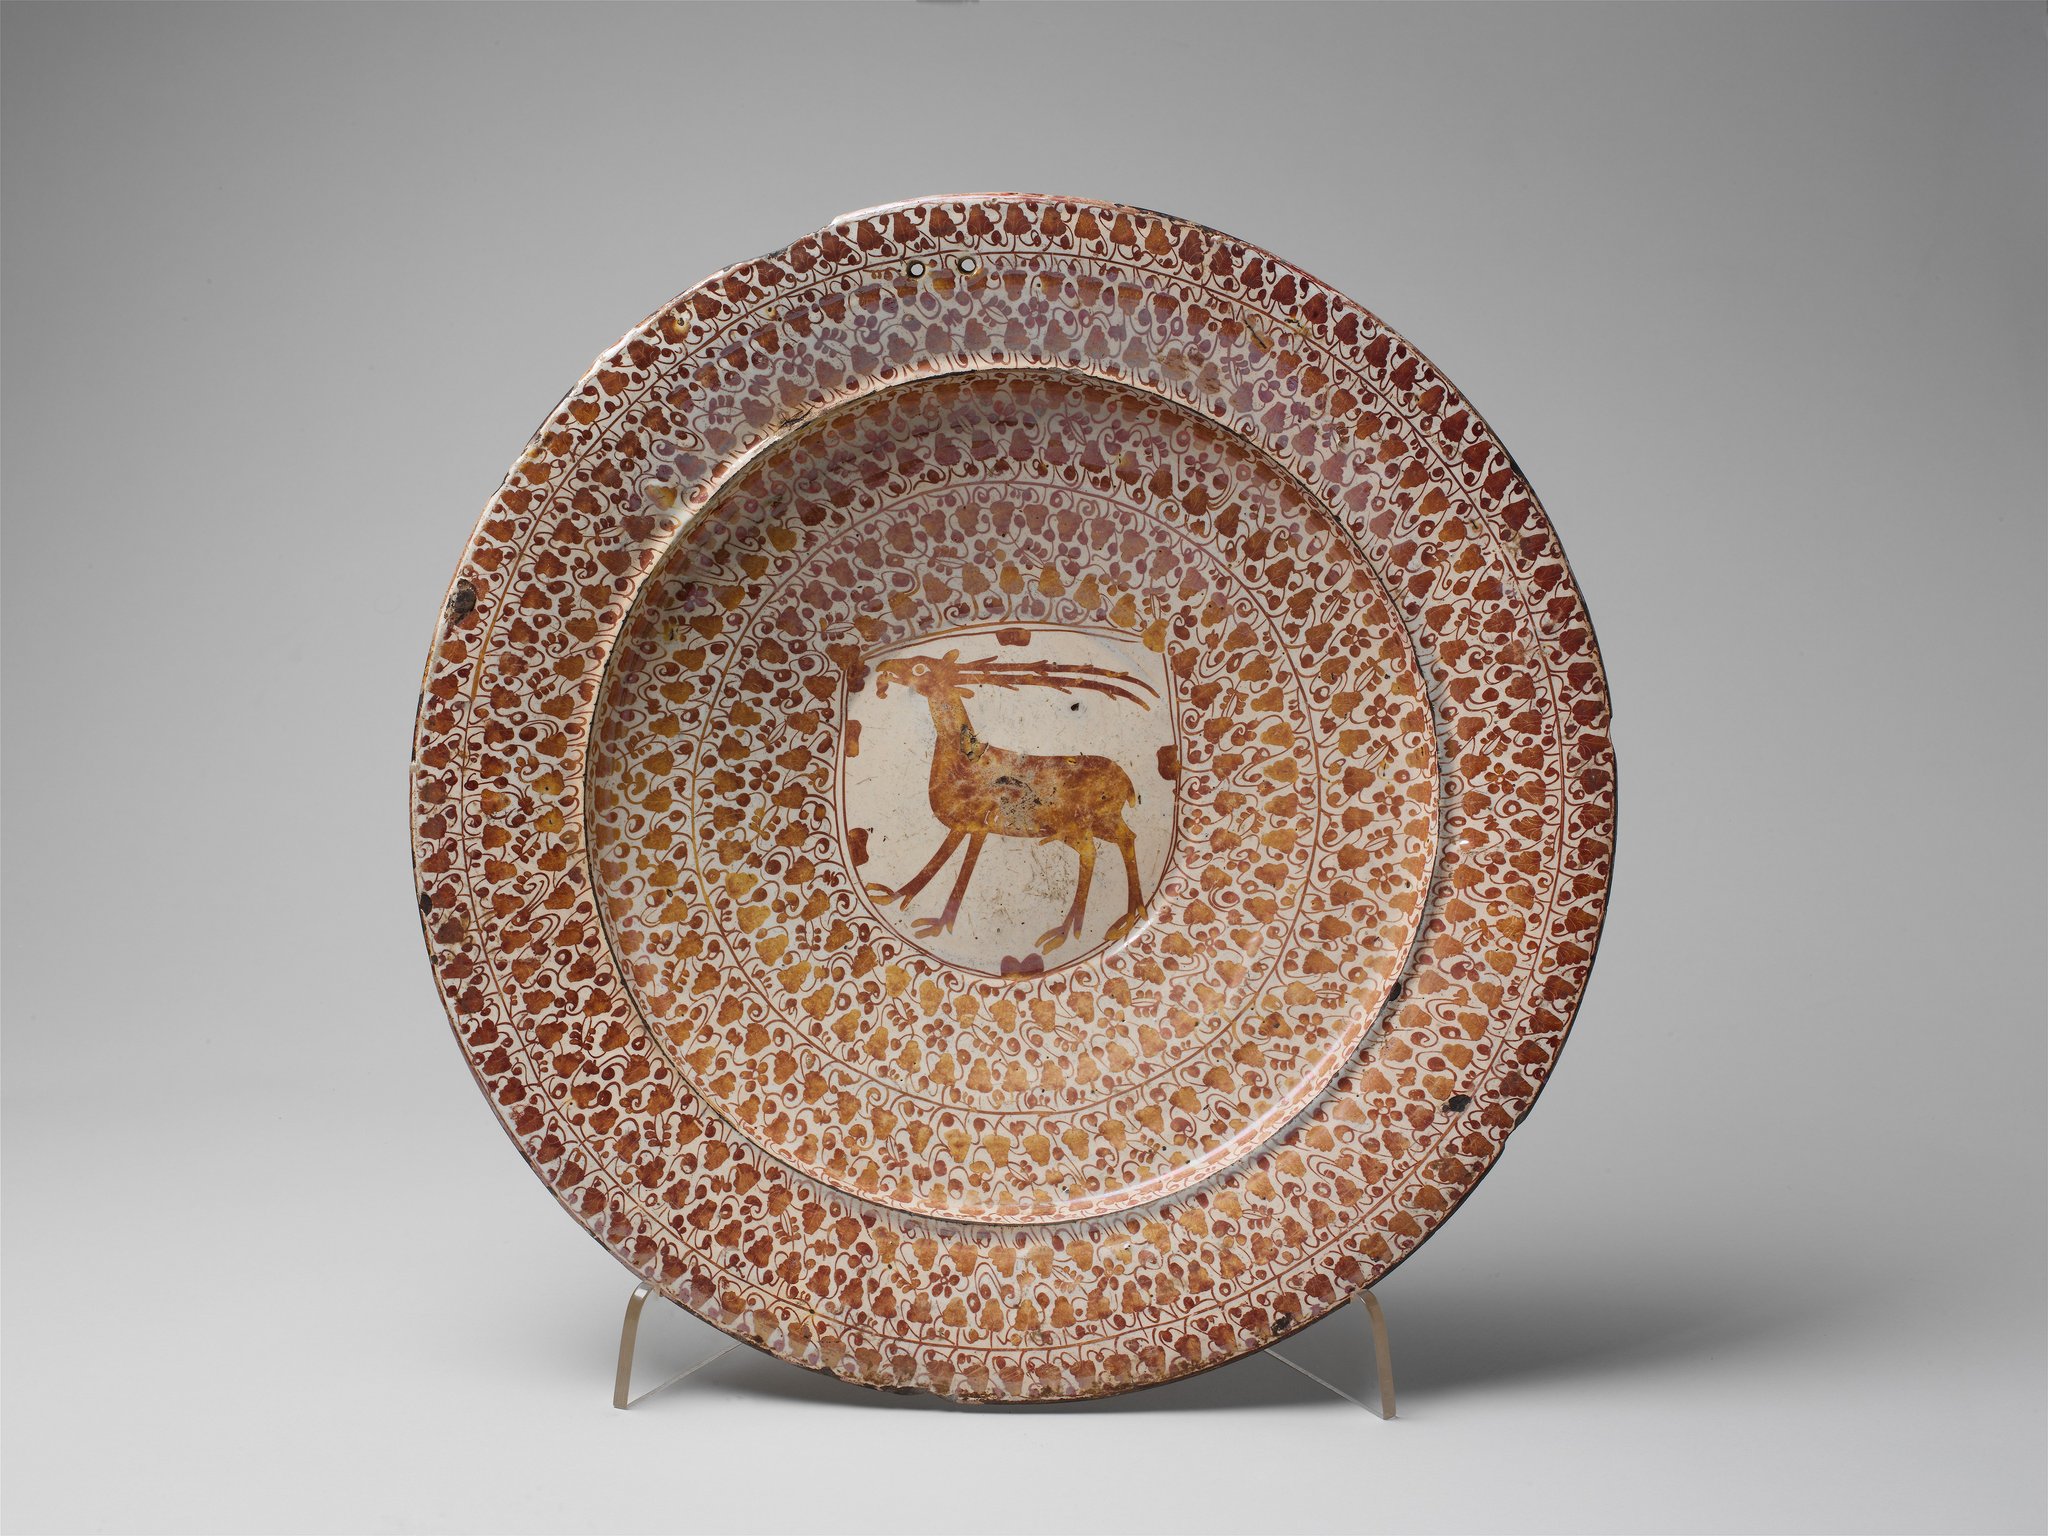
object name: dish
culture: spanish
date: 1430-1470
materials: earthenware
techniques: glazing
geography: spain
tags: deer